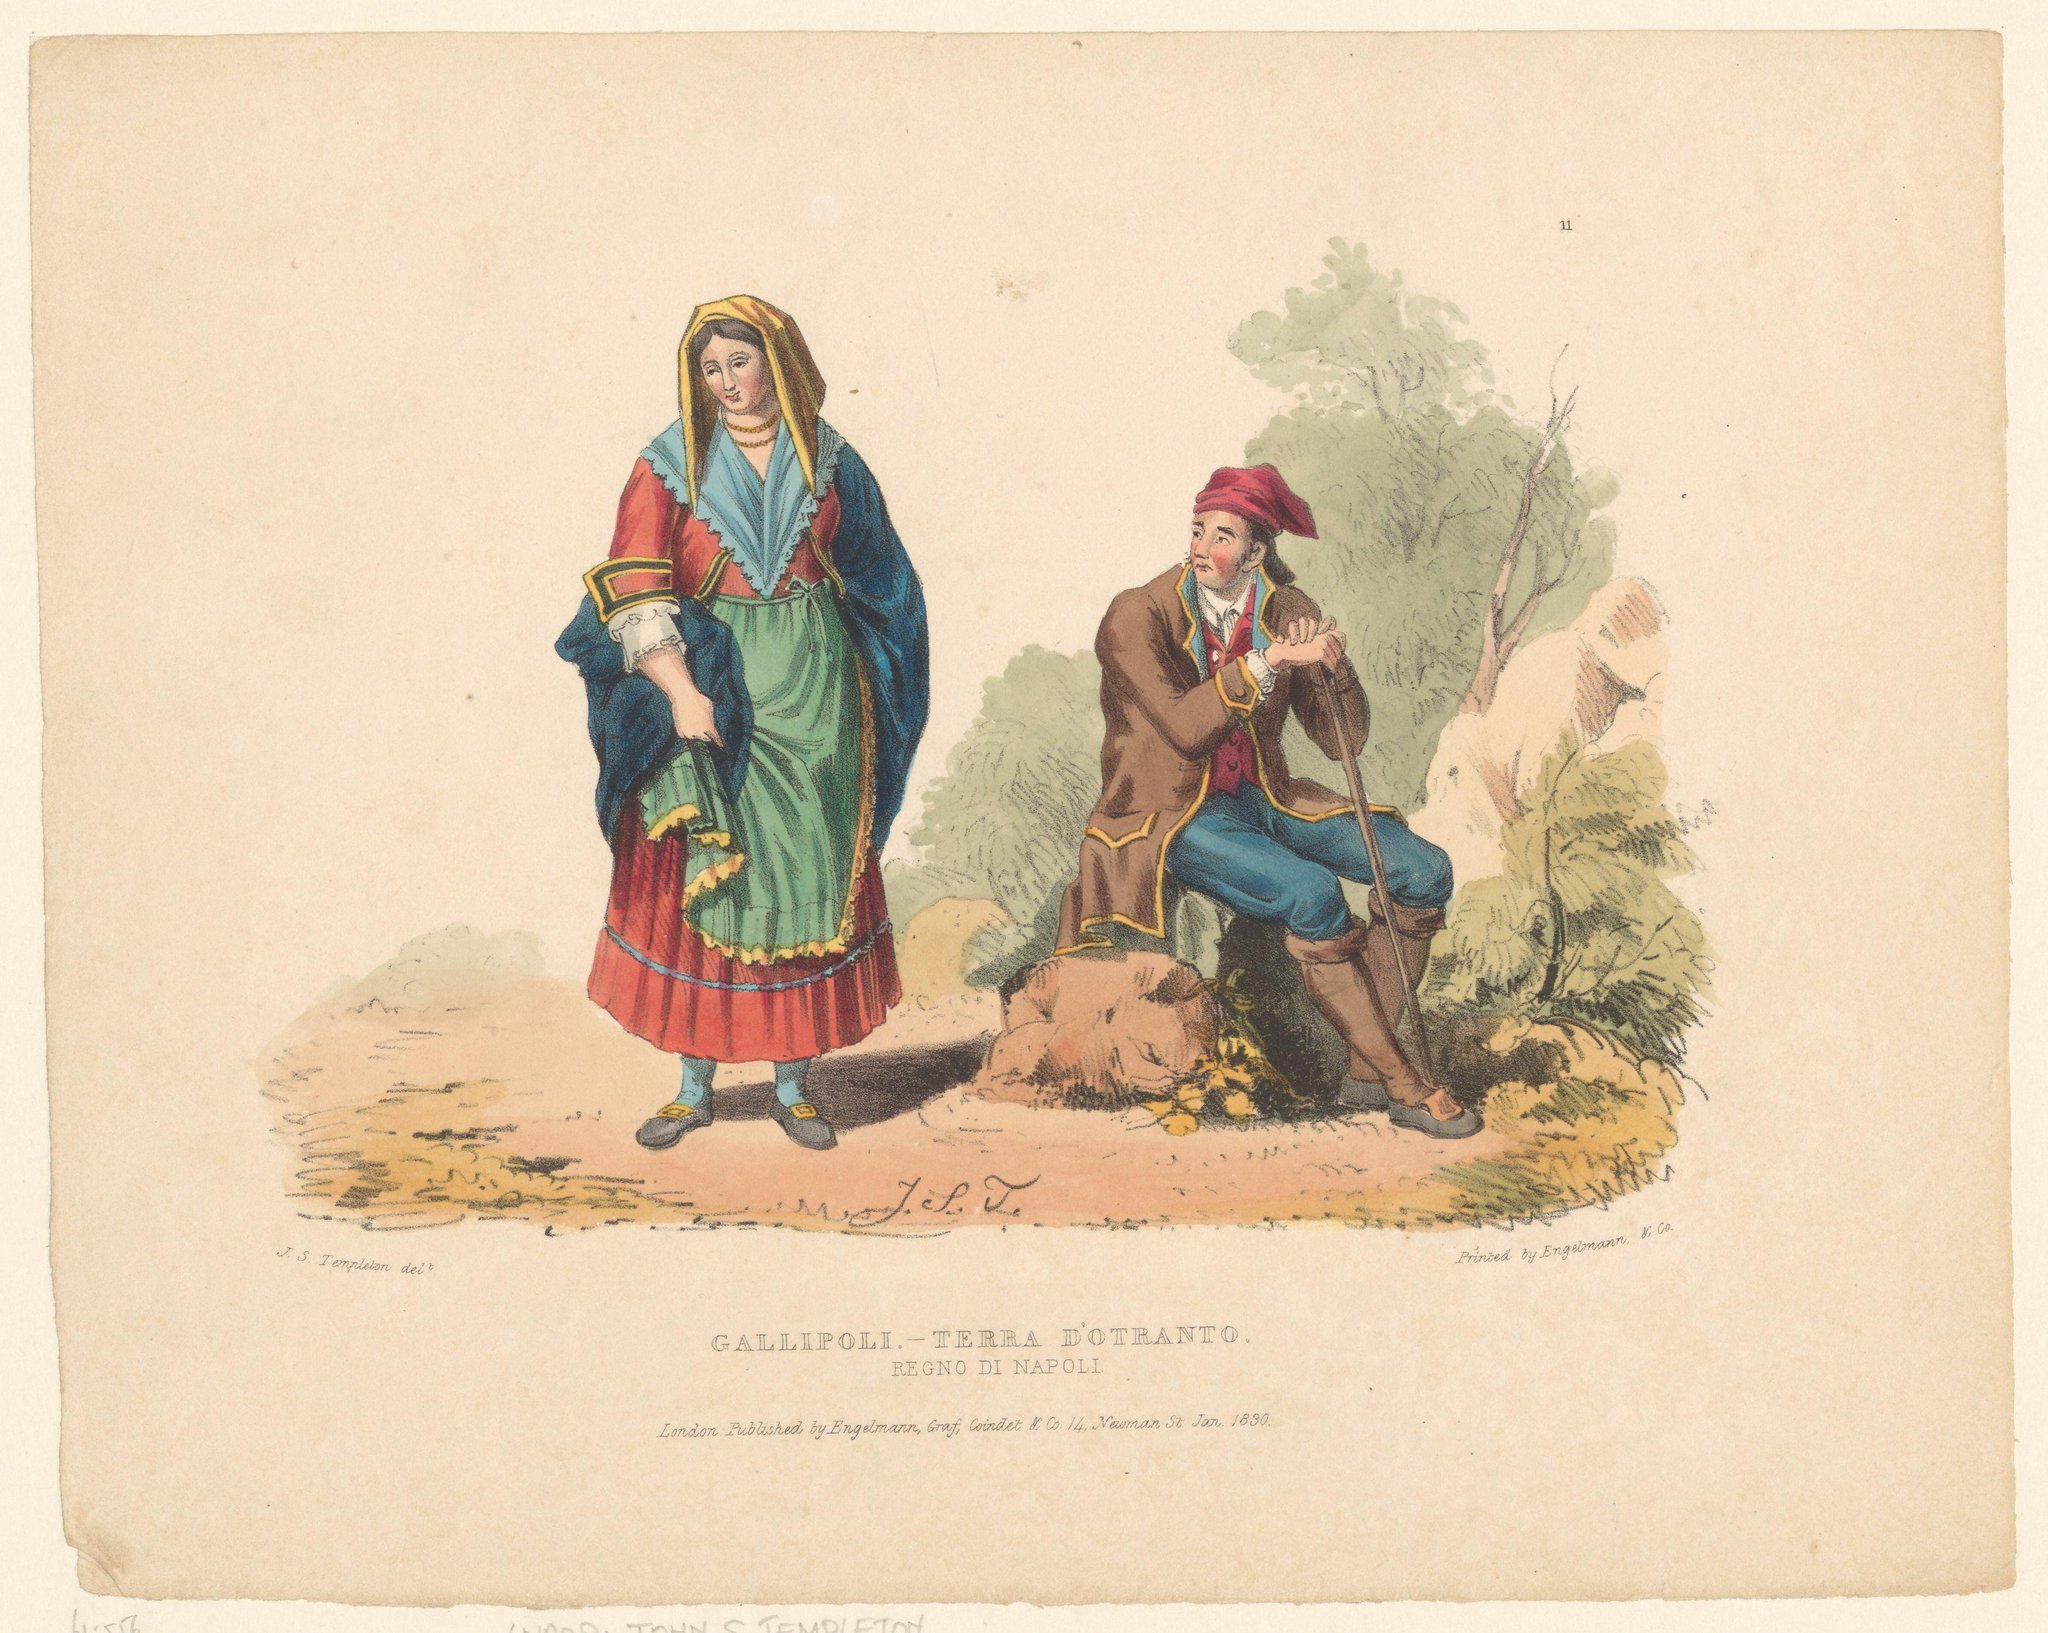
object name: print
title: The Neapolitan Costume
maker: john samuelson templeton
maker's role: print maker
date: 1830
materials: paper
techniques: hand coloring, lithograph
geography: london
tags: adult woman, walking-stick, staff, adult man, folk costume, regional costume, europeans (with name)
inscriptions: mark: ‘School voor de grafische vakken te Utrecht’, collector's mark: Lugt 2228